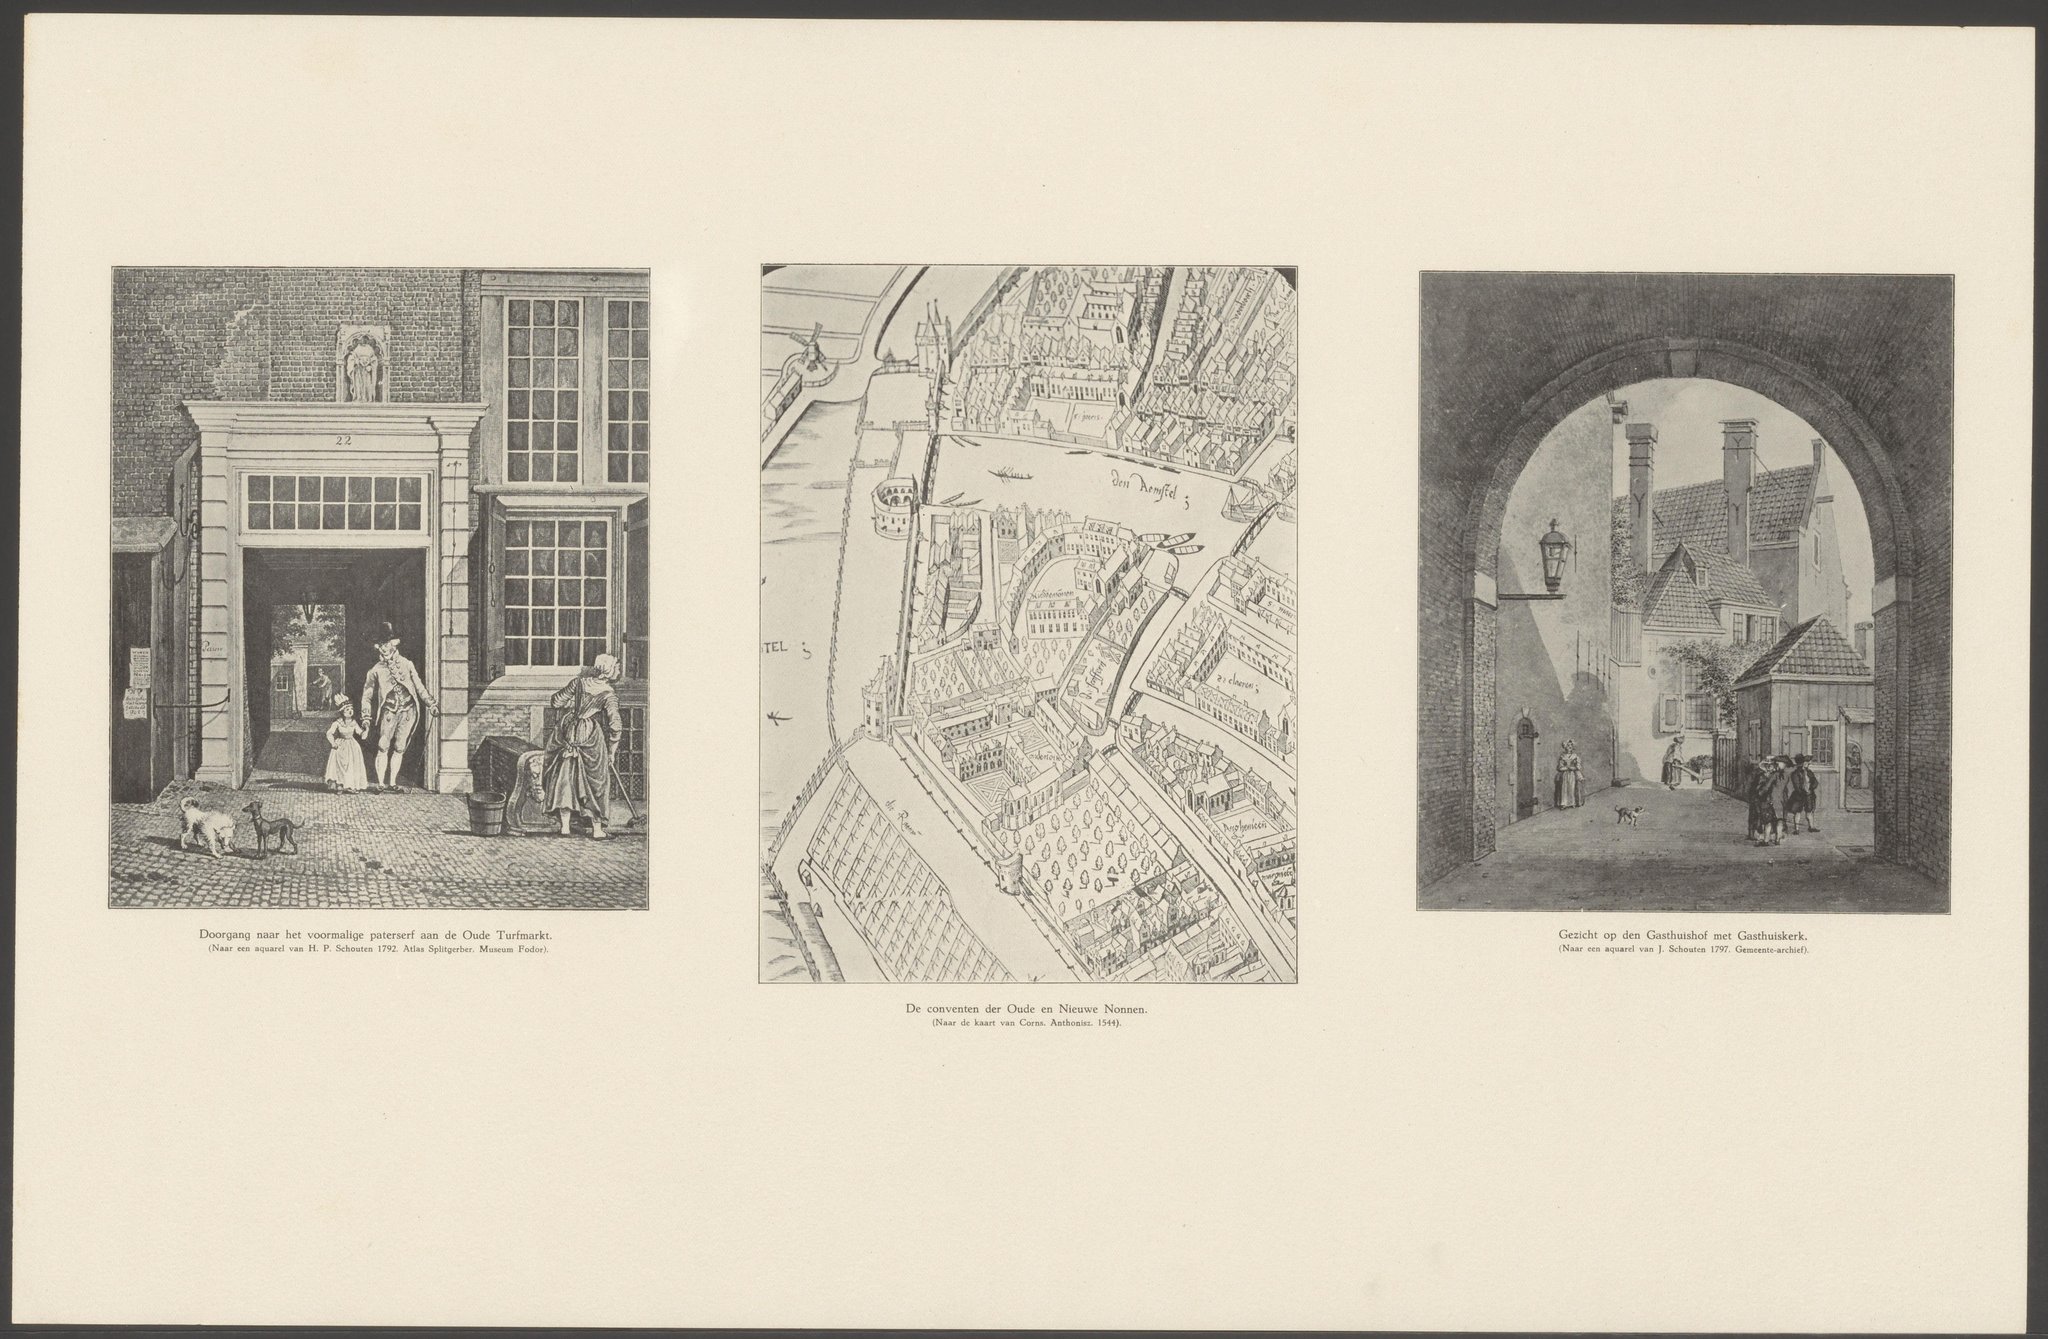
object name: photomechanical print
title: Voorstellingen rond het Binnengasthuis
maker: Anonymous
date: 1912-1970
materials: paper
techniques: letterpress printing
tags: hospital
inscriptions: collector's mark: Lugt 1641b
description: Drie losse voorstellingen over het Binnengasthuis, met de doorgang naar het voormalige paterserf, de conventen der Oude en Nieuwe Nonnen en het Gasthuishof en Gasthuiskerk. Onderwerpsrubriek binnen de Atlas Amsterdam: Armwezen en liefdadige instellingen: I. Stadsinrichtingen: Binnengasthuis.